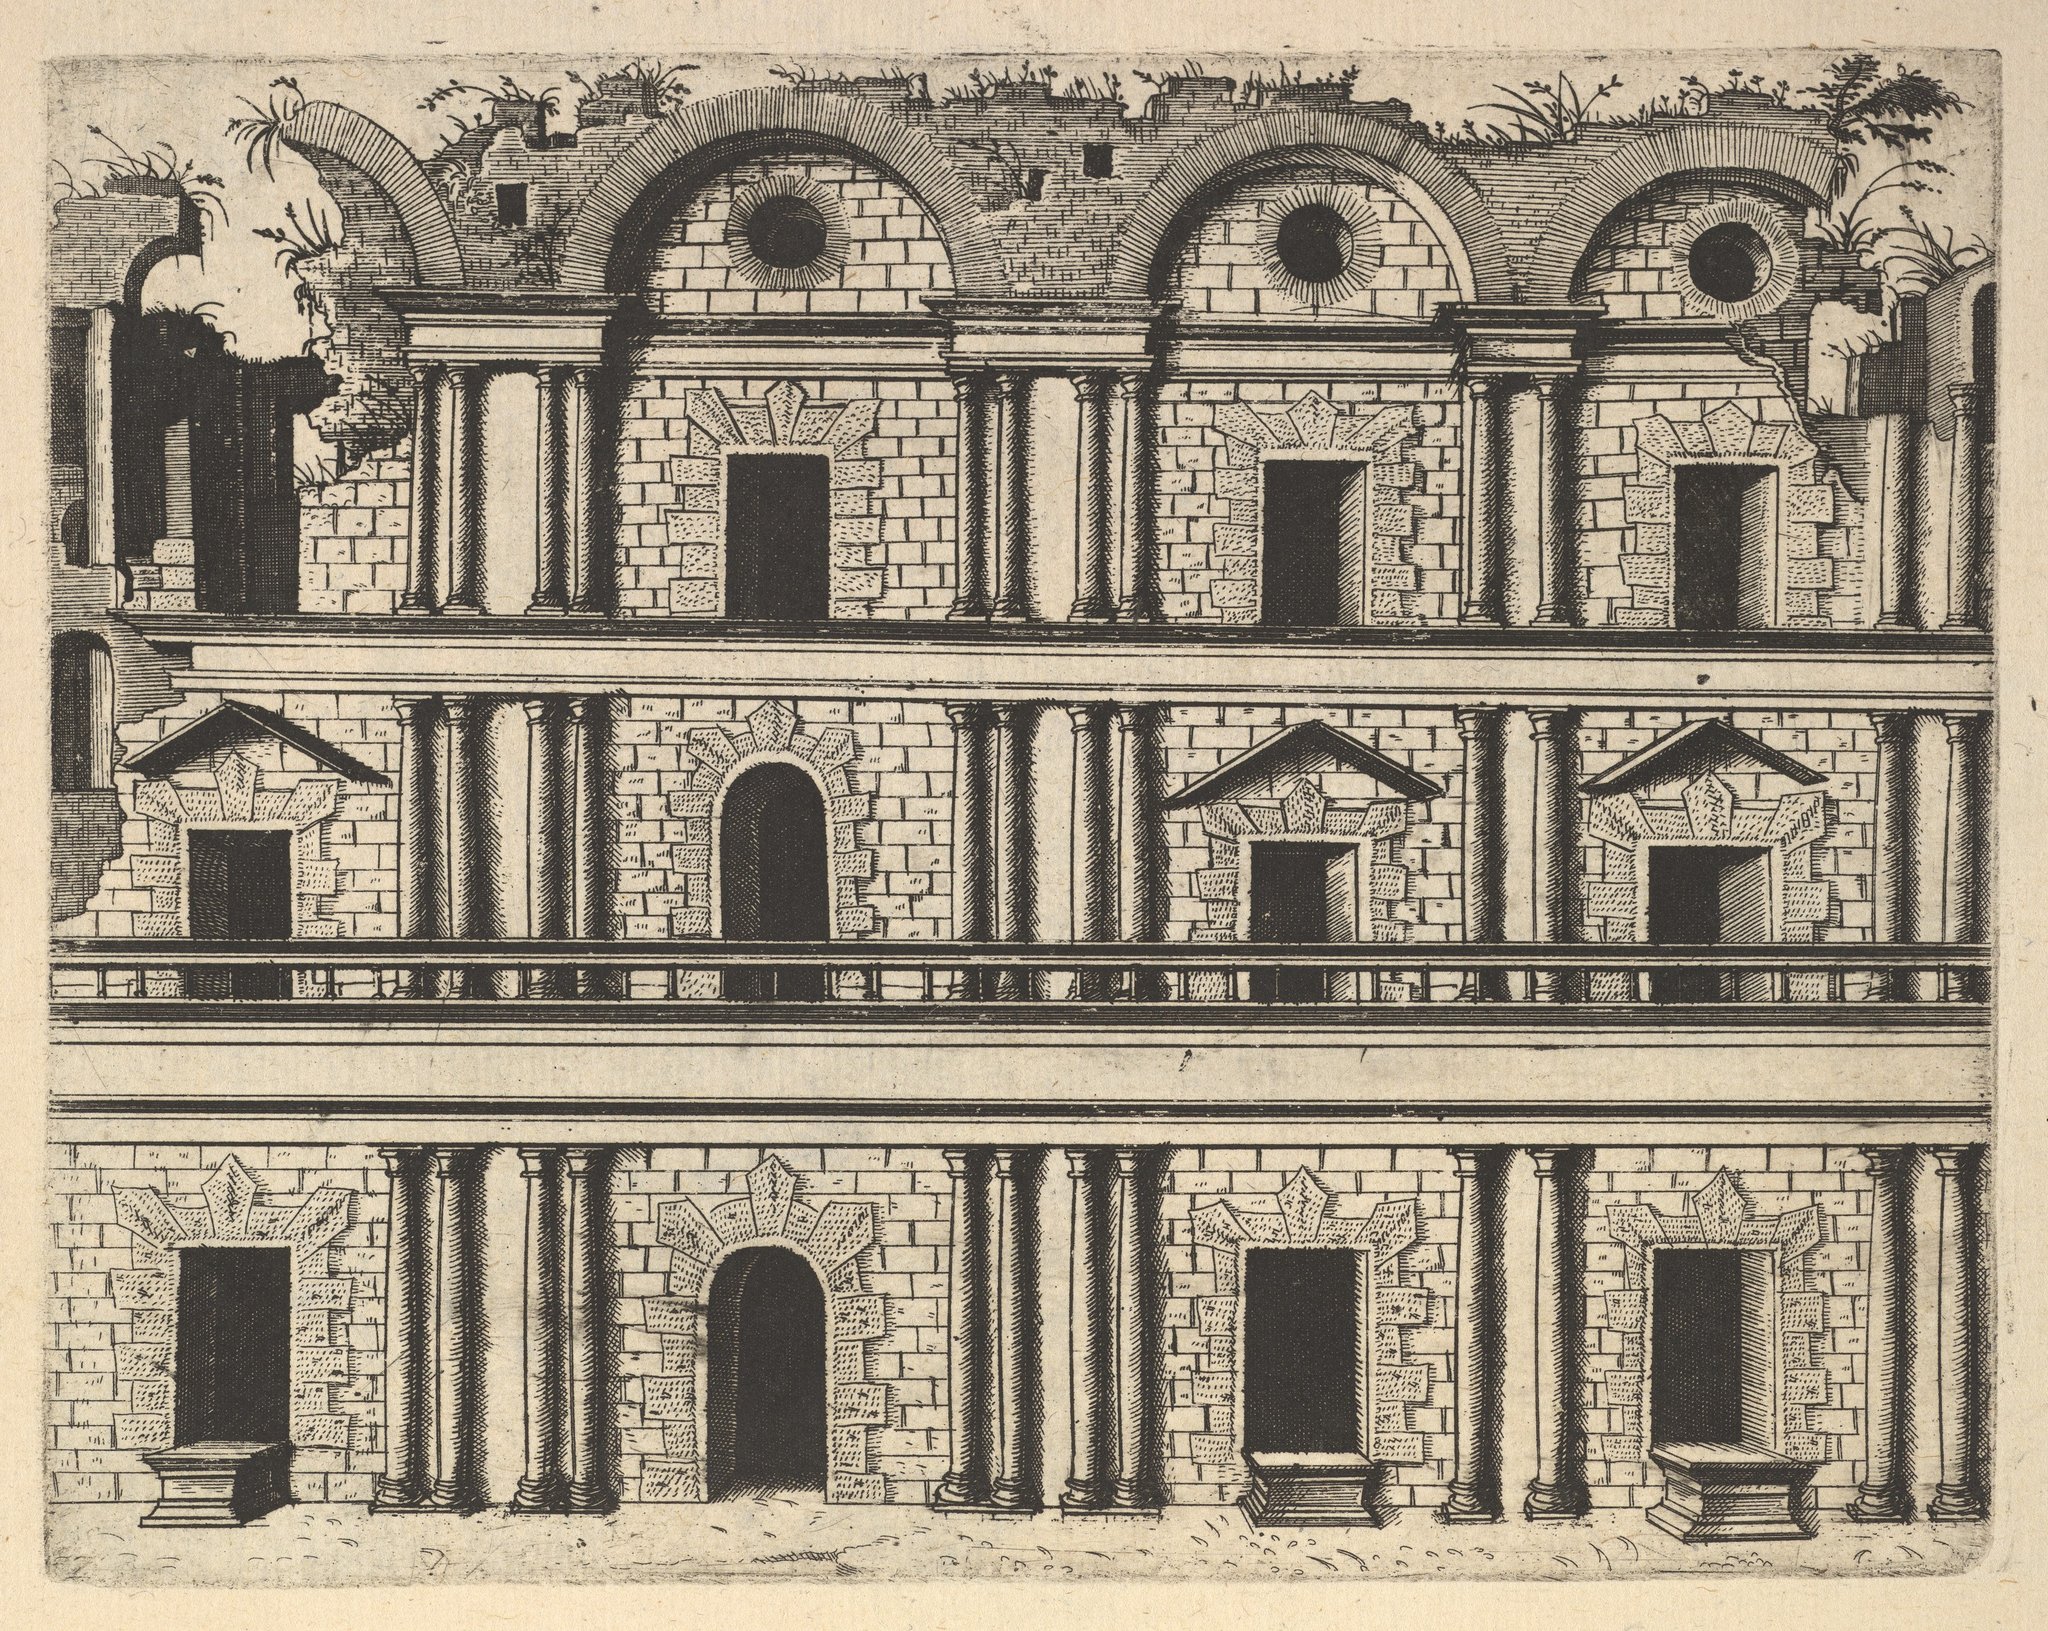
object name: book print ornament architecture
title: Ruin of a Palace Facade [Palatium M. Agrippa] from the series 'Ruinarum variarum fabricarum delineationes pictoribus caeterisque id genus artificibus multum utiles'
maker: lambert suavius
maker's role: artist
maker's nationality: netherlandish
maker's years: 1510-1576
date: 1554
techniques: etching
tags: architecture,arches,palaces